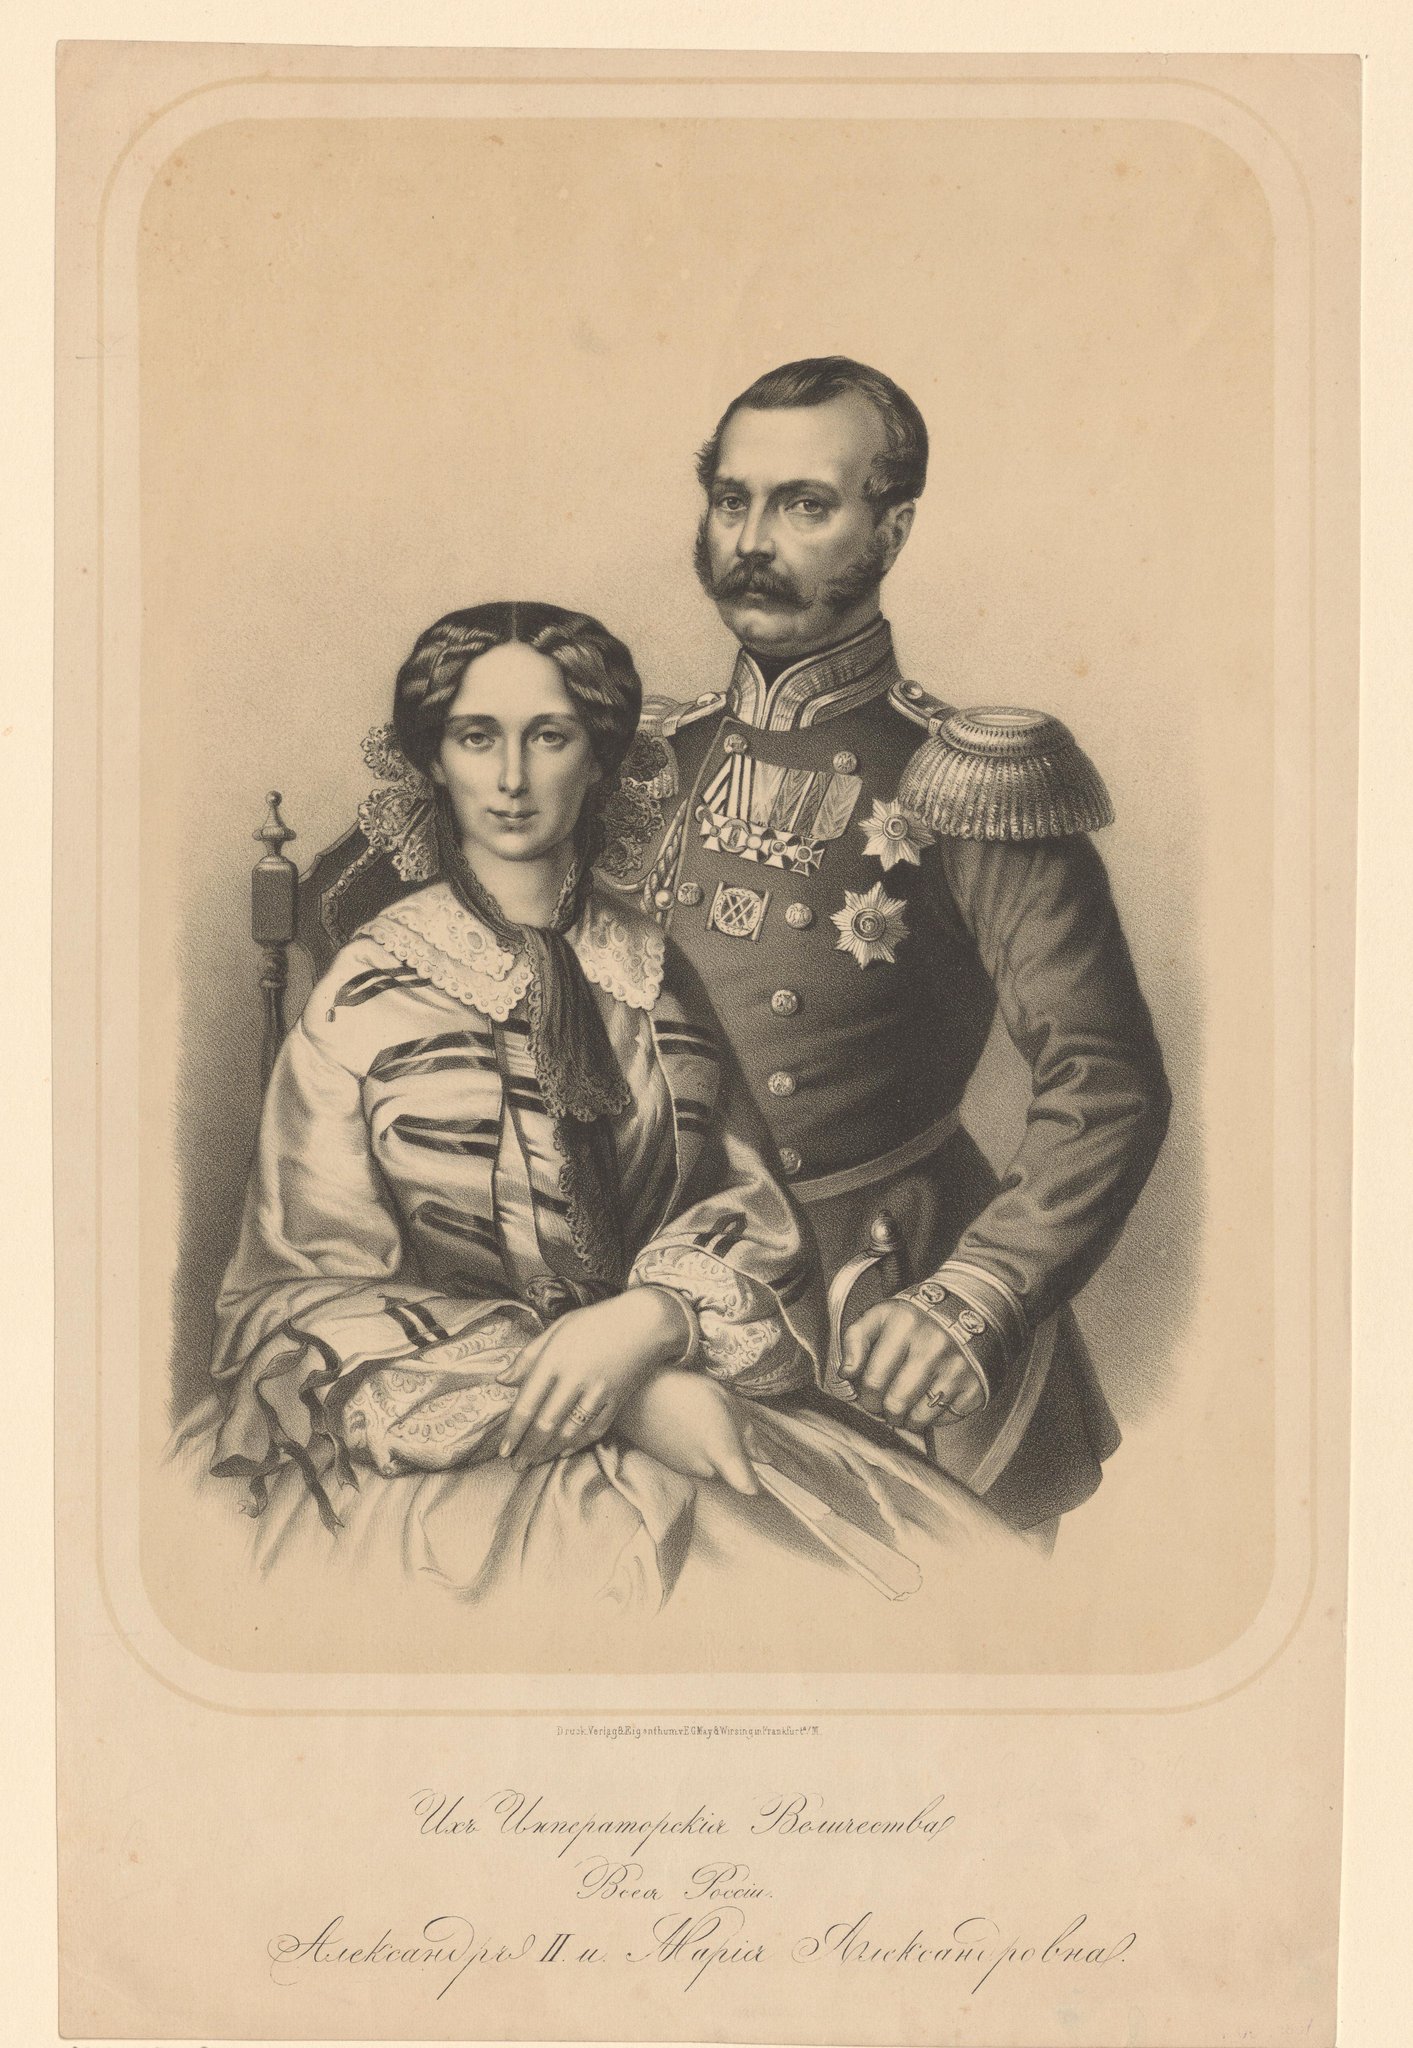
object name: print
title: Portret van tsaar Alexander II en Marie van Hessen-Darmstadt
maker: Anonymous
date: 1850-1863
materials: paper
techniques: tone lithography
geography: frankfurt am main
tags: historical persons - bb - woman, historical persons, emperor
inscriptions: collector's mark: Lugt 2760, collector's mark: Lugt 2228